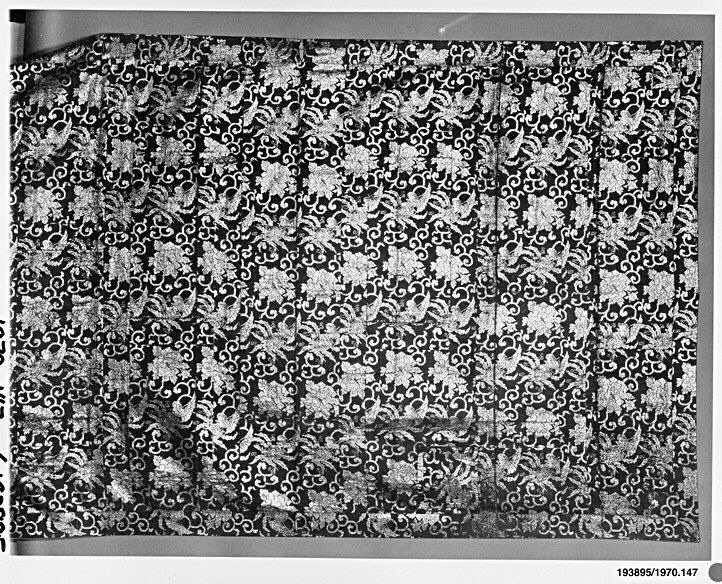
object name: robe, priest's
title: Priest's Robe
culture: japanese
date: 1701-1800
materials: metal thread, silk